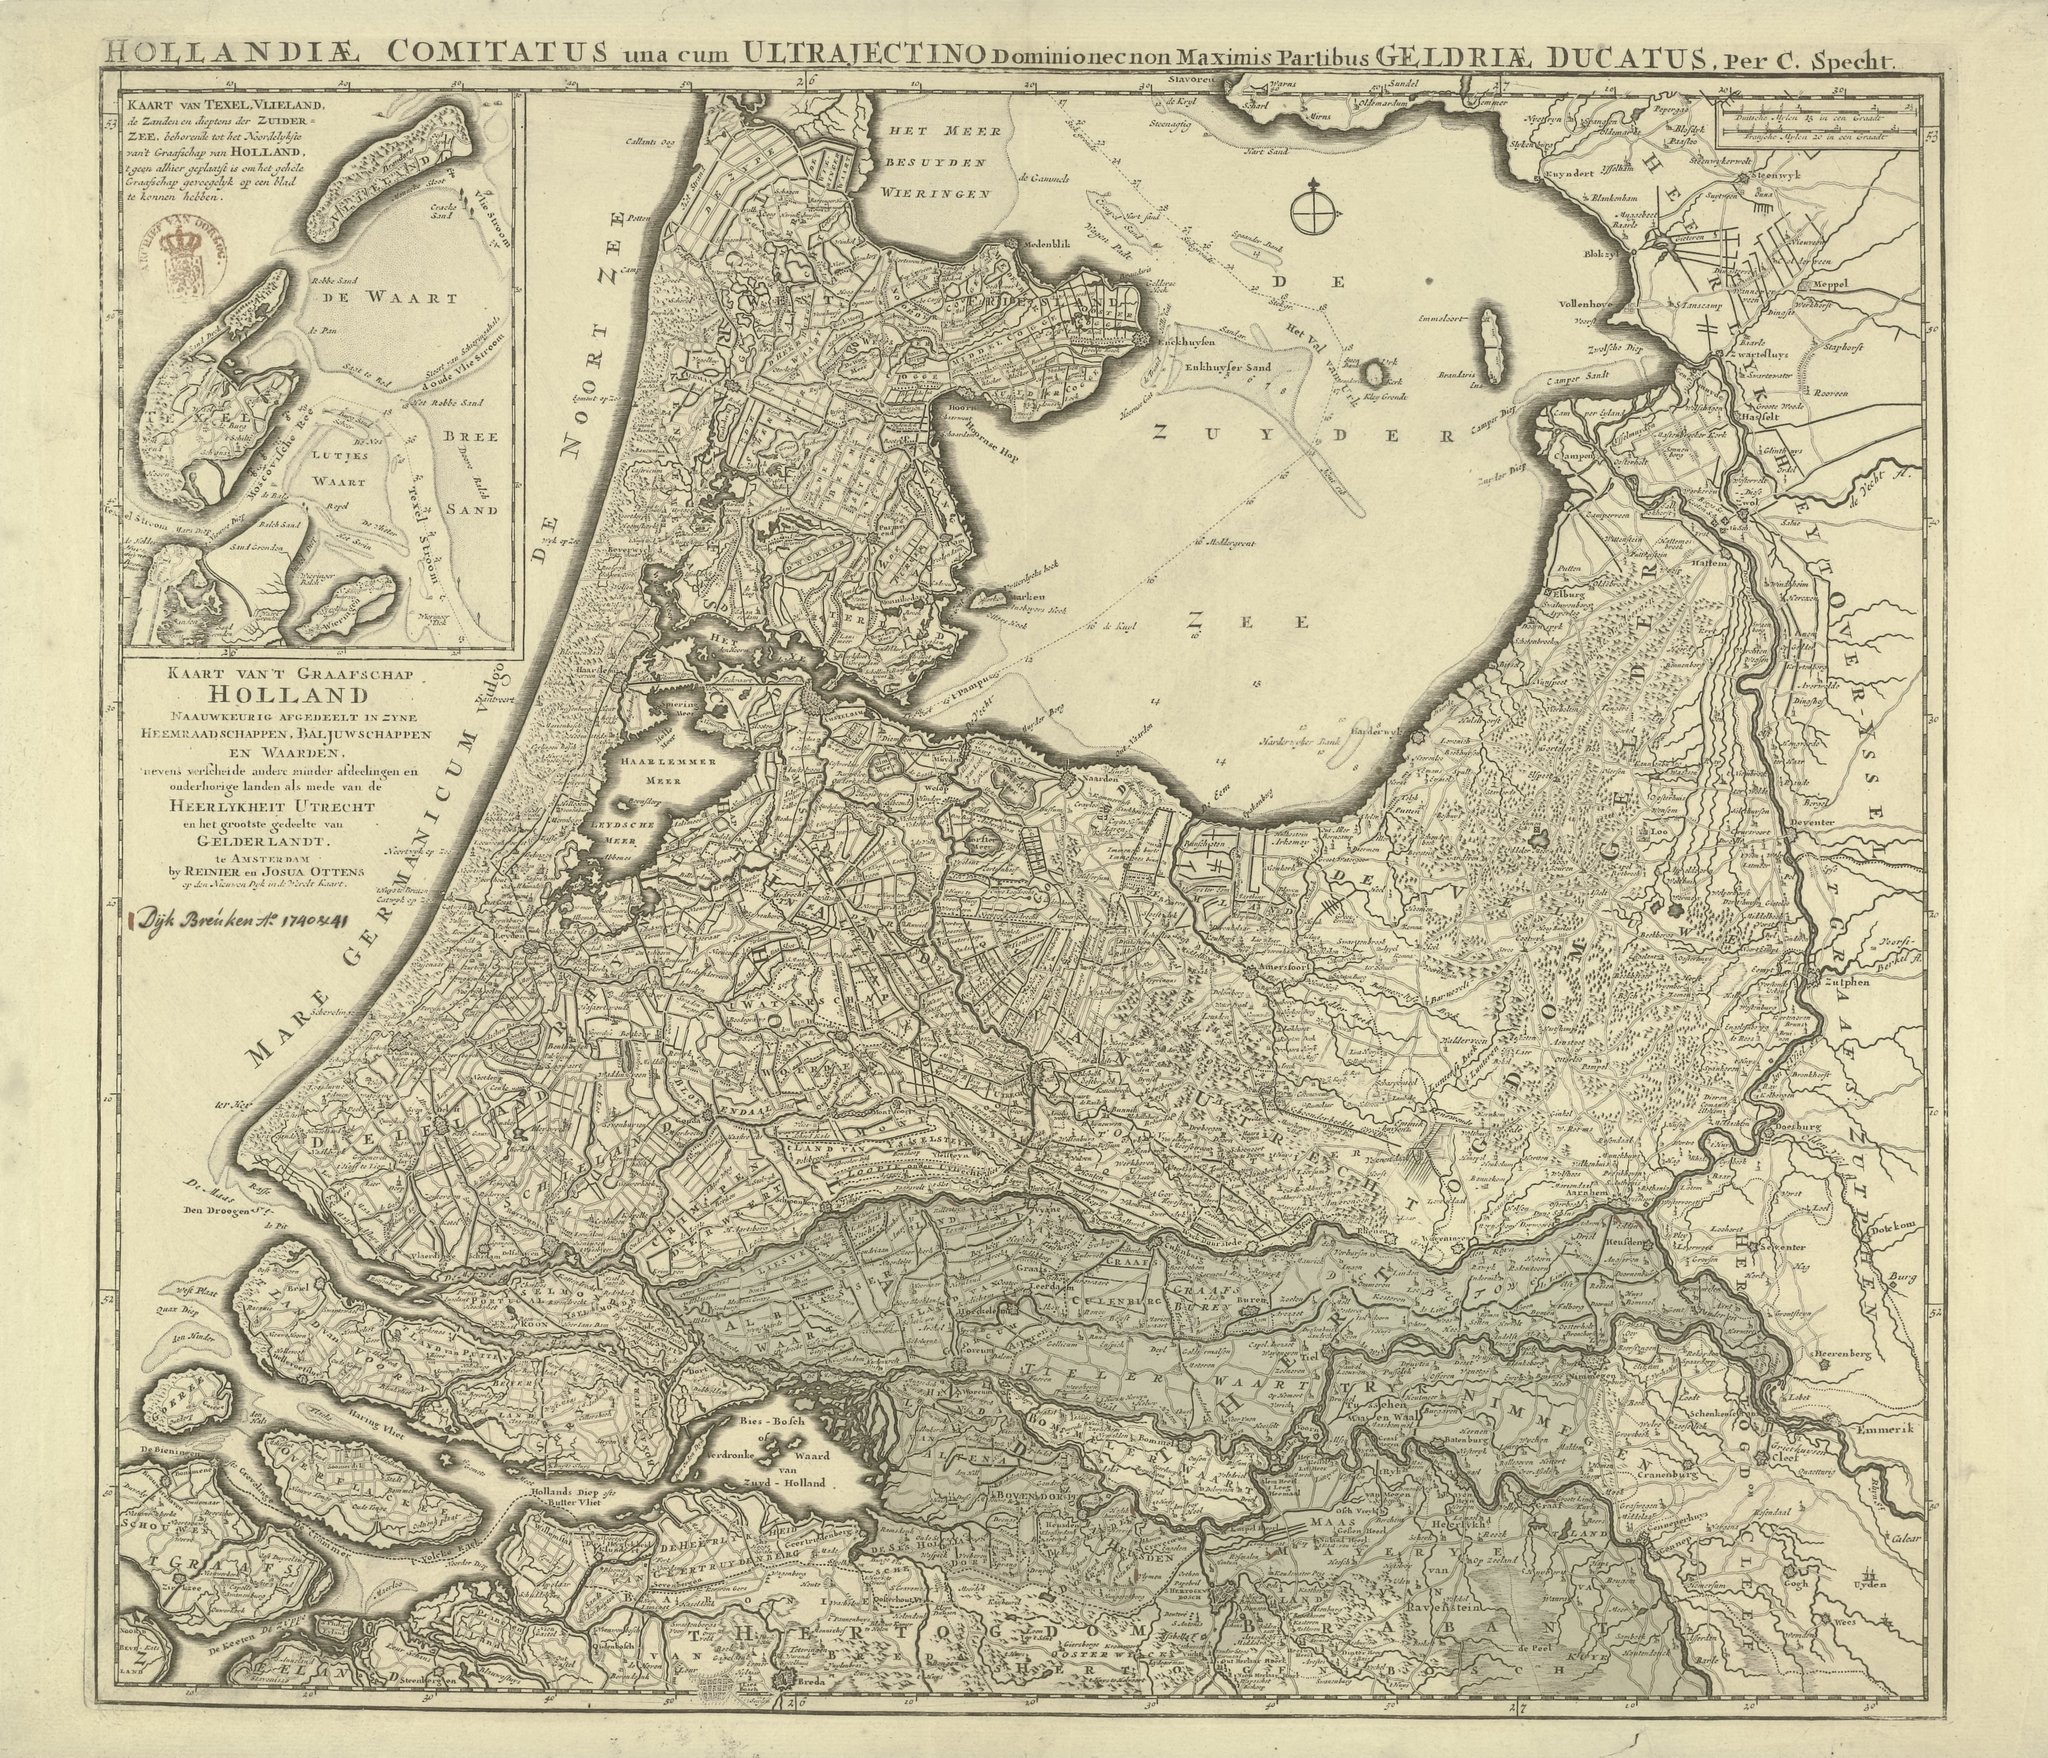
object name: print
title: Kaart van de provincies Holland, Utrecht en Gelderland met de delen die bij de dijkbreuken in 1740-1741 onder water zijn gelopen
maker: caspar specht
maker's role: print maker, publisher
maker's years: 1654-1710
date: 1740-1741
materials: paper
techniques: engraving, hand coloring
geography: northern netherlands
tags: maps of separate countries or regions, utrecht, gelderland, holland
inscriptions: collector's mark: Lugt 2228, collector's mark: Lugt 19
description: Kaart van de provincies Holland, Utrecht en Gelderland waarop de delen die bij de dijkbreuken en watersnood in december 1740 en november 1741 onder water zijn gelopen groen zijn ingekleurd. Linksboven een inzet met de eilanden Texel en Vlieland. Hergebruik van een oudere kaart.